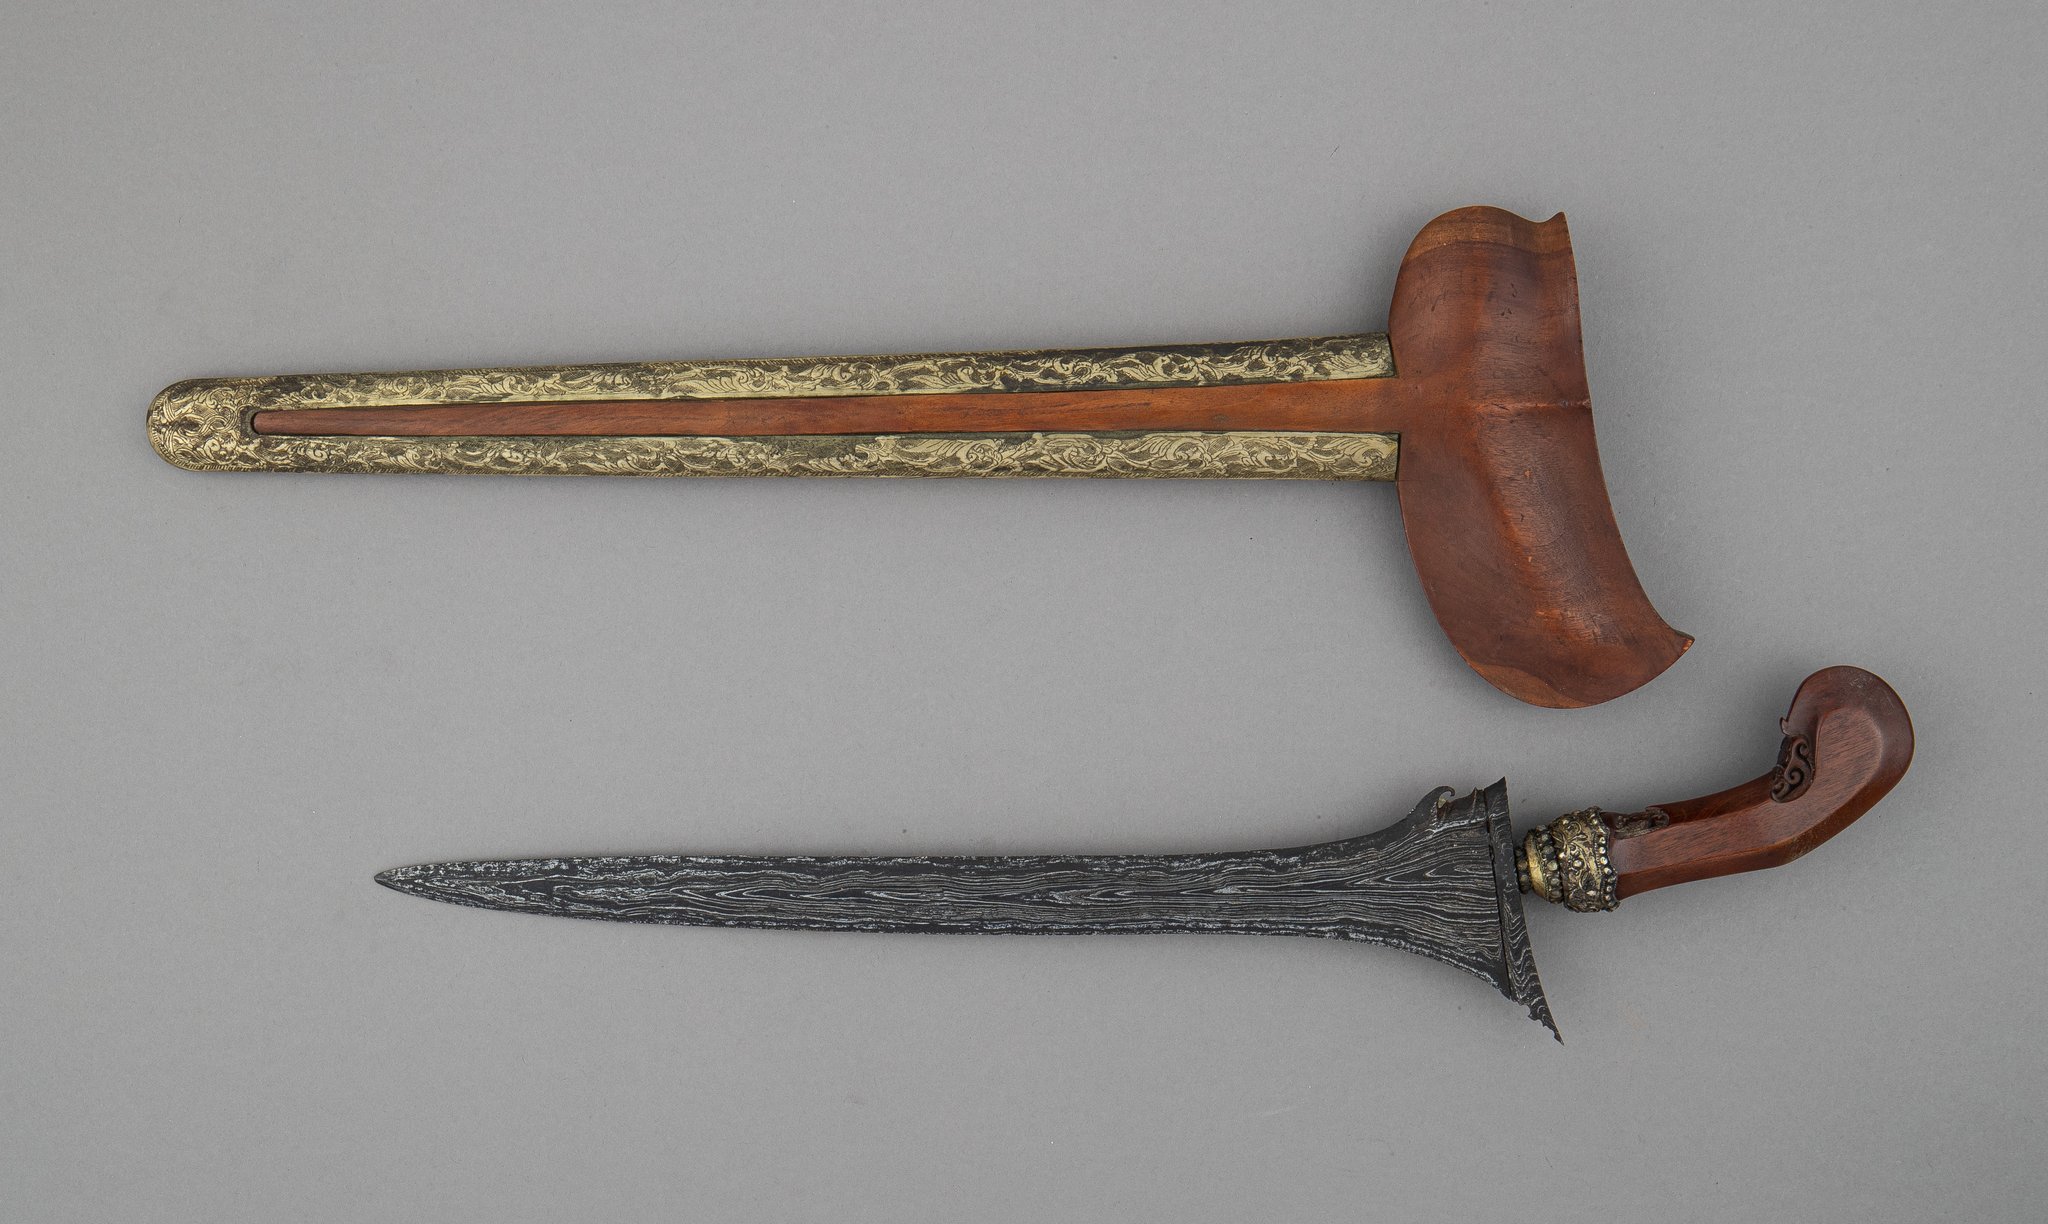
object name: kris with sheath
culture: javanese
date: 1501-1900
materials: brass, silver, steel, stone, wood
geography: indonesia